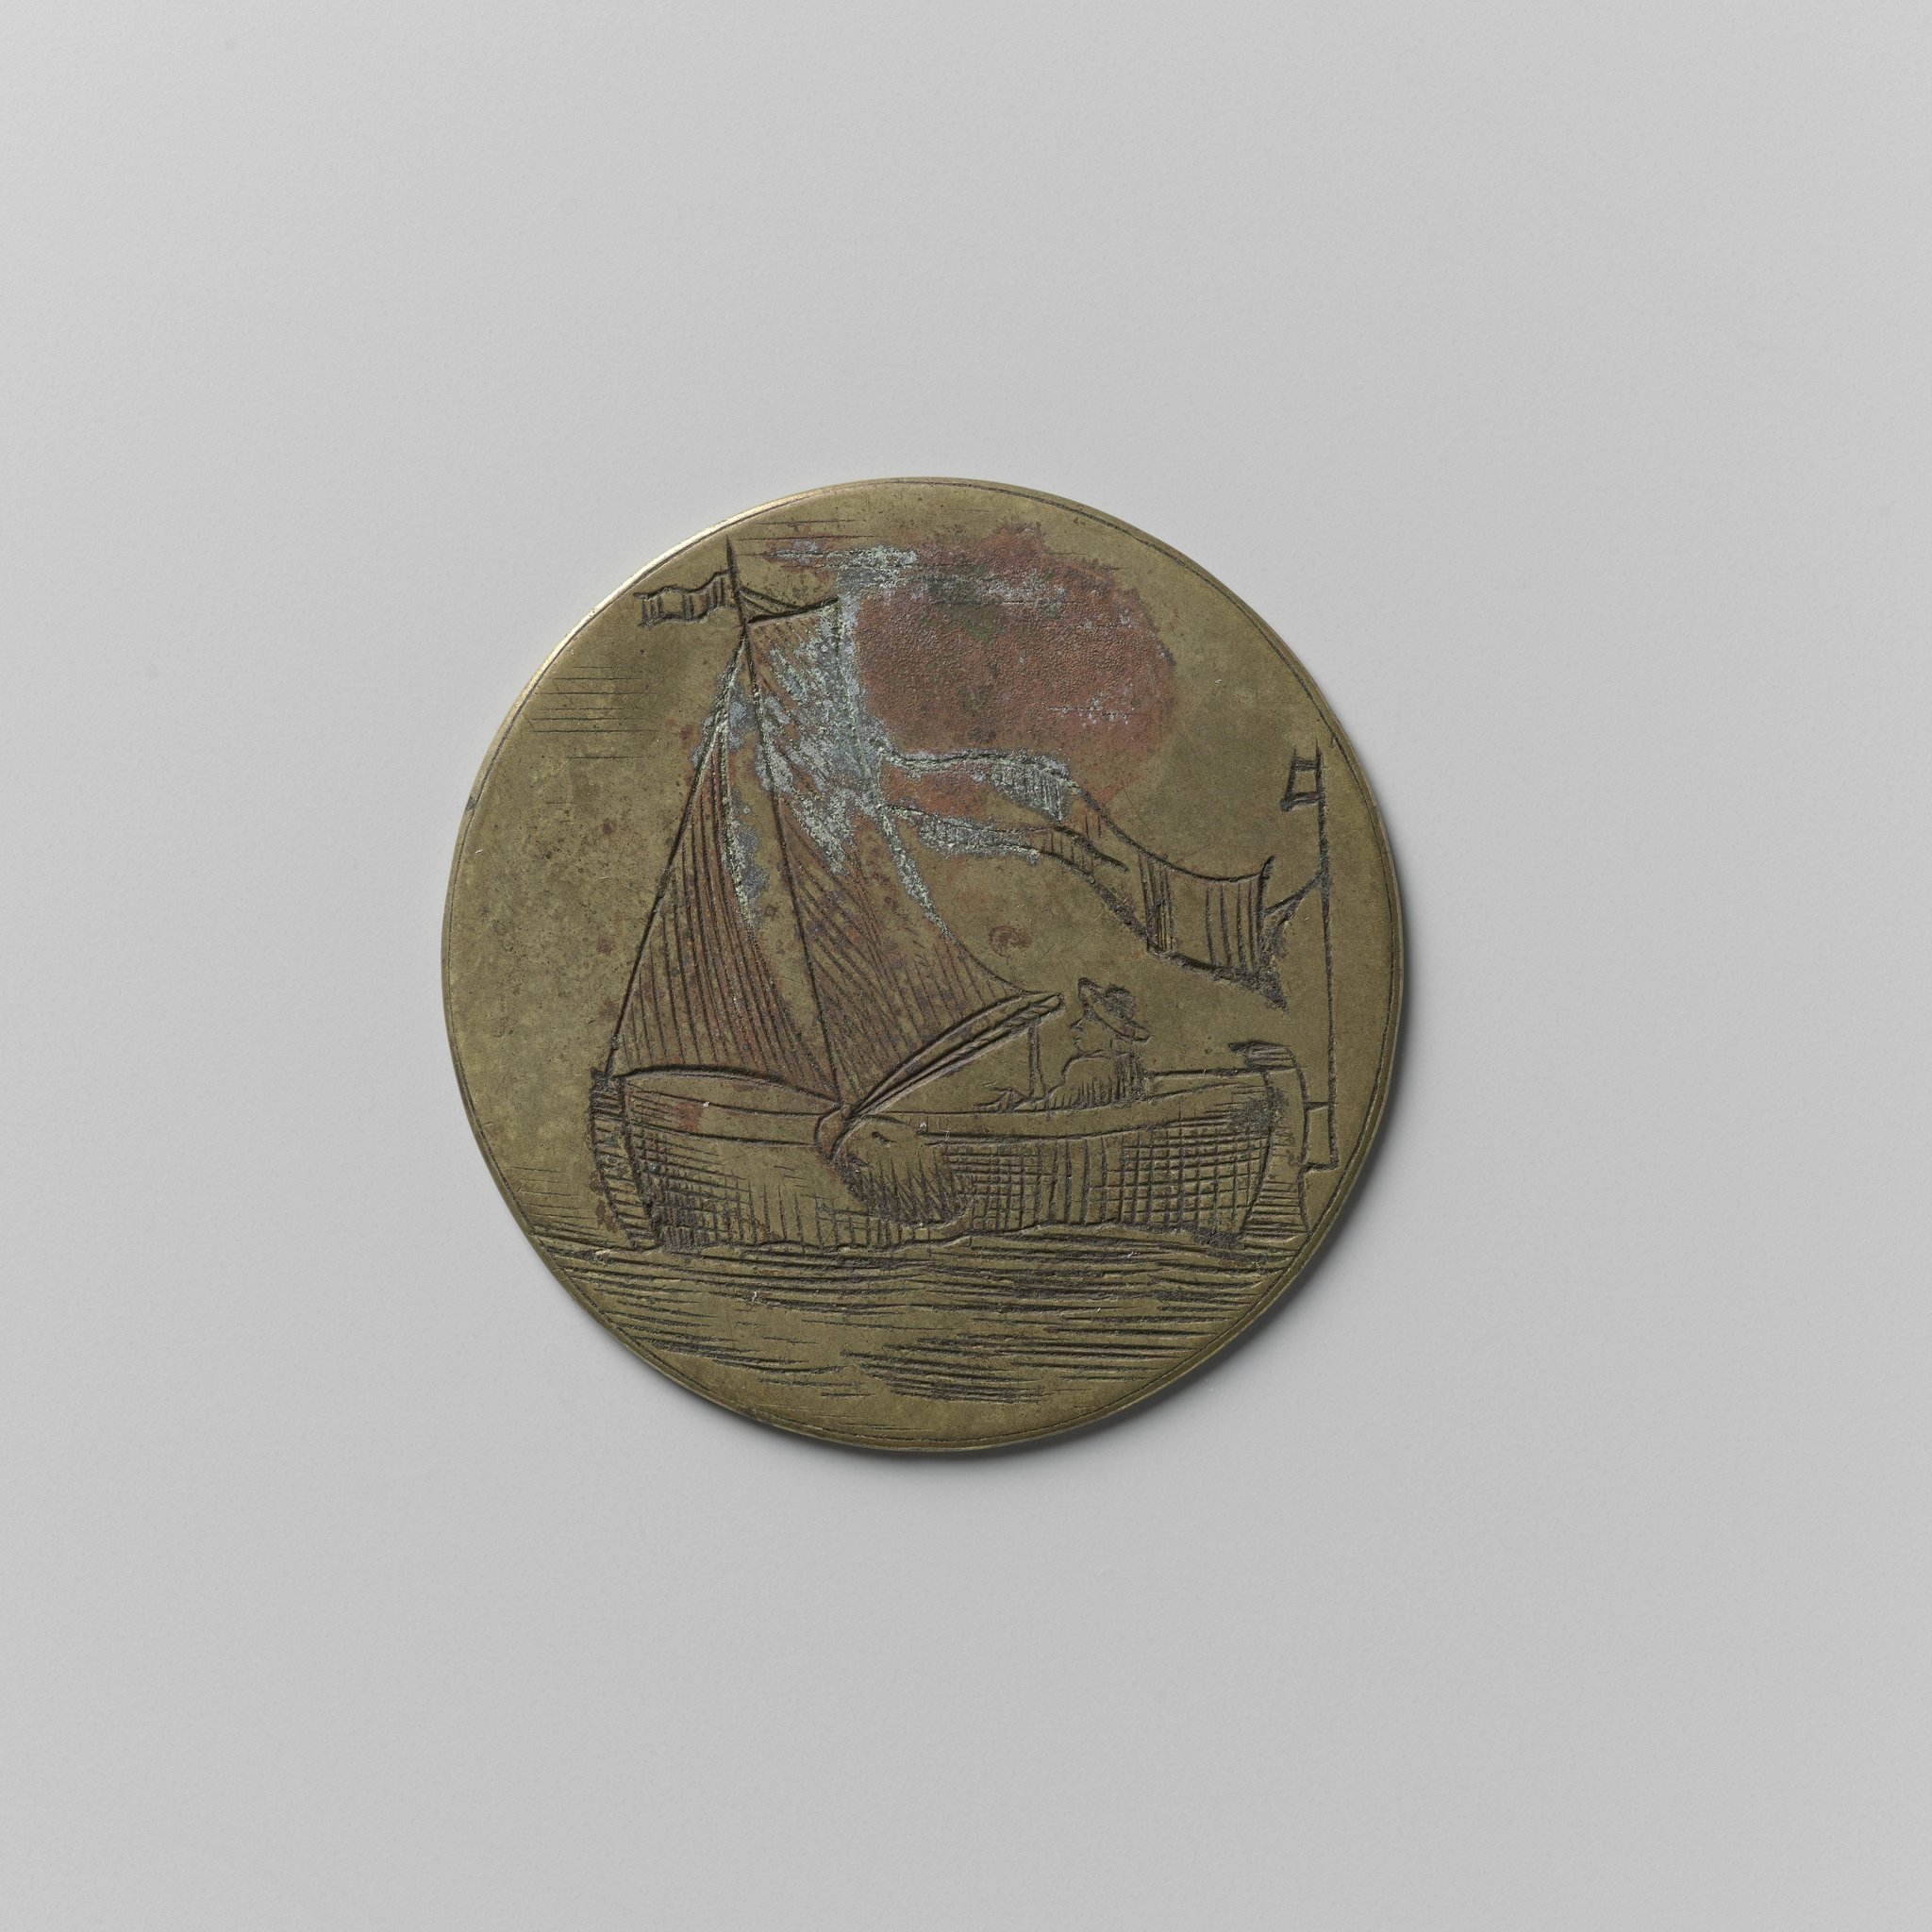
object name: medal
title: Roei-, steiger- en schuitenvoerdersgilde van Amsterdam, gildepenning van Willem de Groote, ligplaats Nieuwe Brug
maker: Anonymous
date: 1794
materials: brass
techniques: engraving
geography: amsterdam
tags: amsterdam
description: Messing penning. Voorzijde: naar links varende zeilboot; op achterplecht: zittende man en vlag. Keerzijde: opschrift boven huismerk en hart met daarin letters W, D en G tussen monogram van letters N en B.